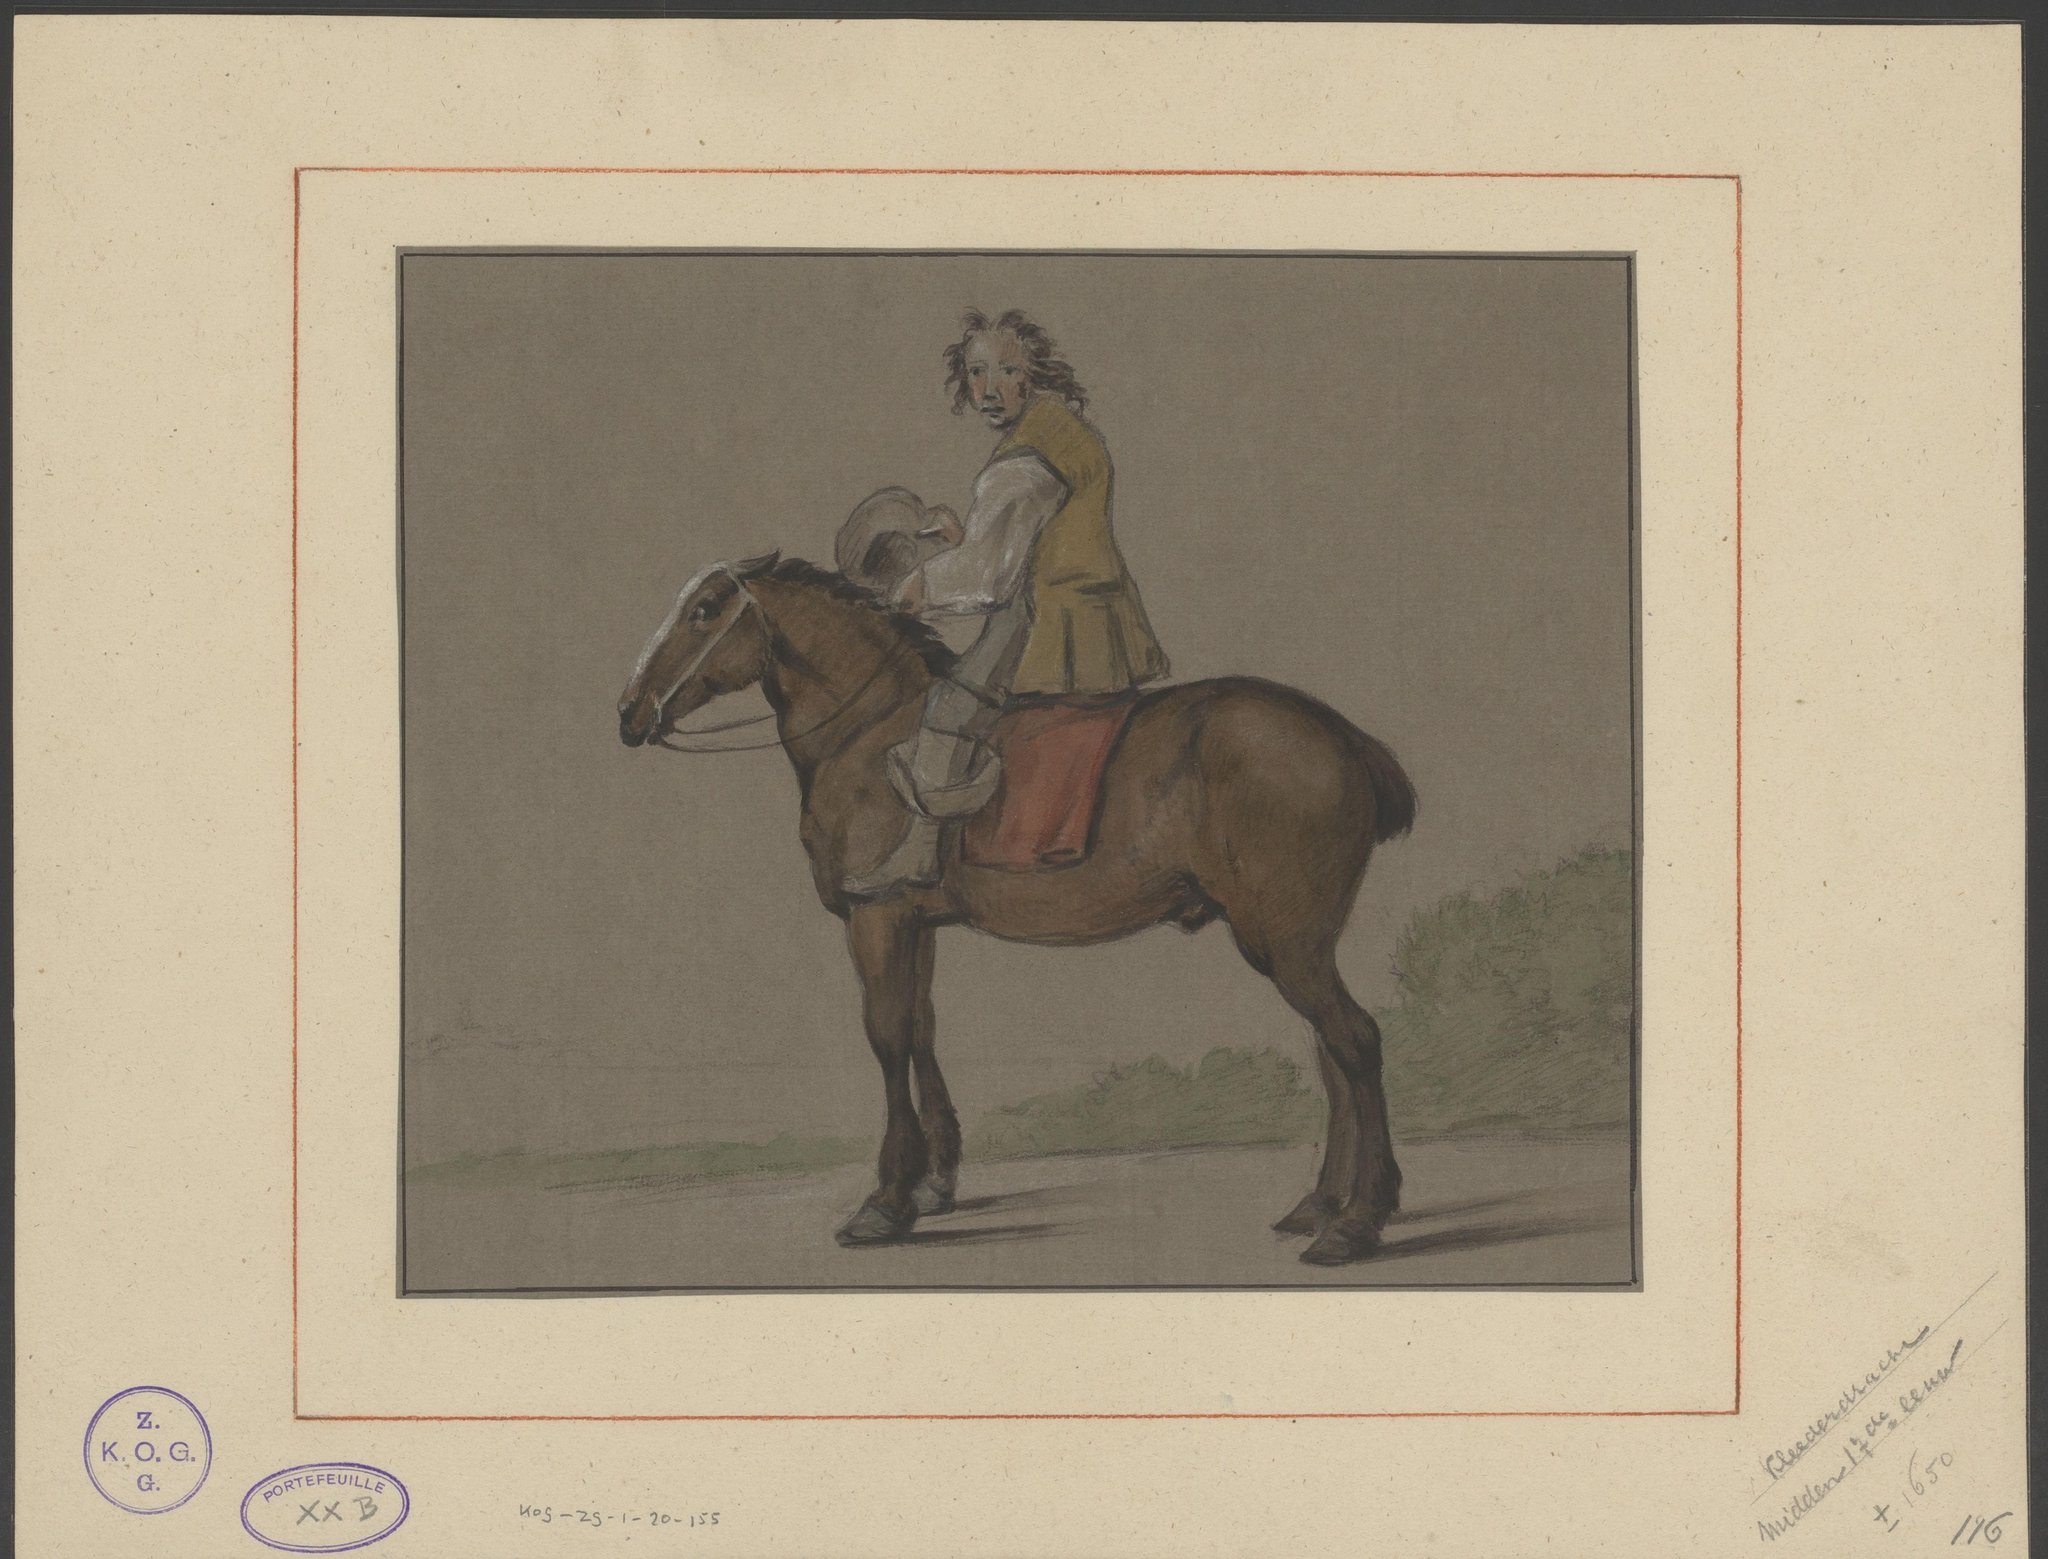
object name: drawing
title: Ruiter te paard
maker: Anonymous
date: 1800-1899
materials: chalk, paint, paper, watercolor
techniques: brush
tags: riding on animal other than horse, ass, or mule, historical costume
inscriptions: collector's mark: Lugt 1641, stamp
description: Onderwerpsrubrieken binnen de Atlas Zeden en Gewoonten: Zeden en Gewoonten in Engeren Zin, De Kleeding, Kleederdrachten (tijdvakken), Het midden der 17de eeuw. (De Fransche mode).